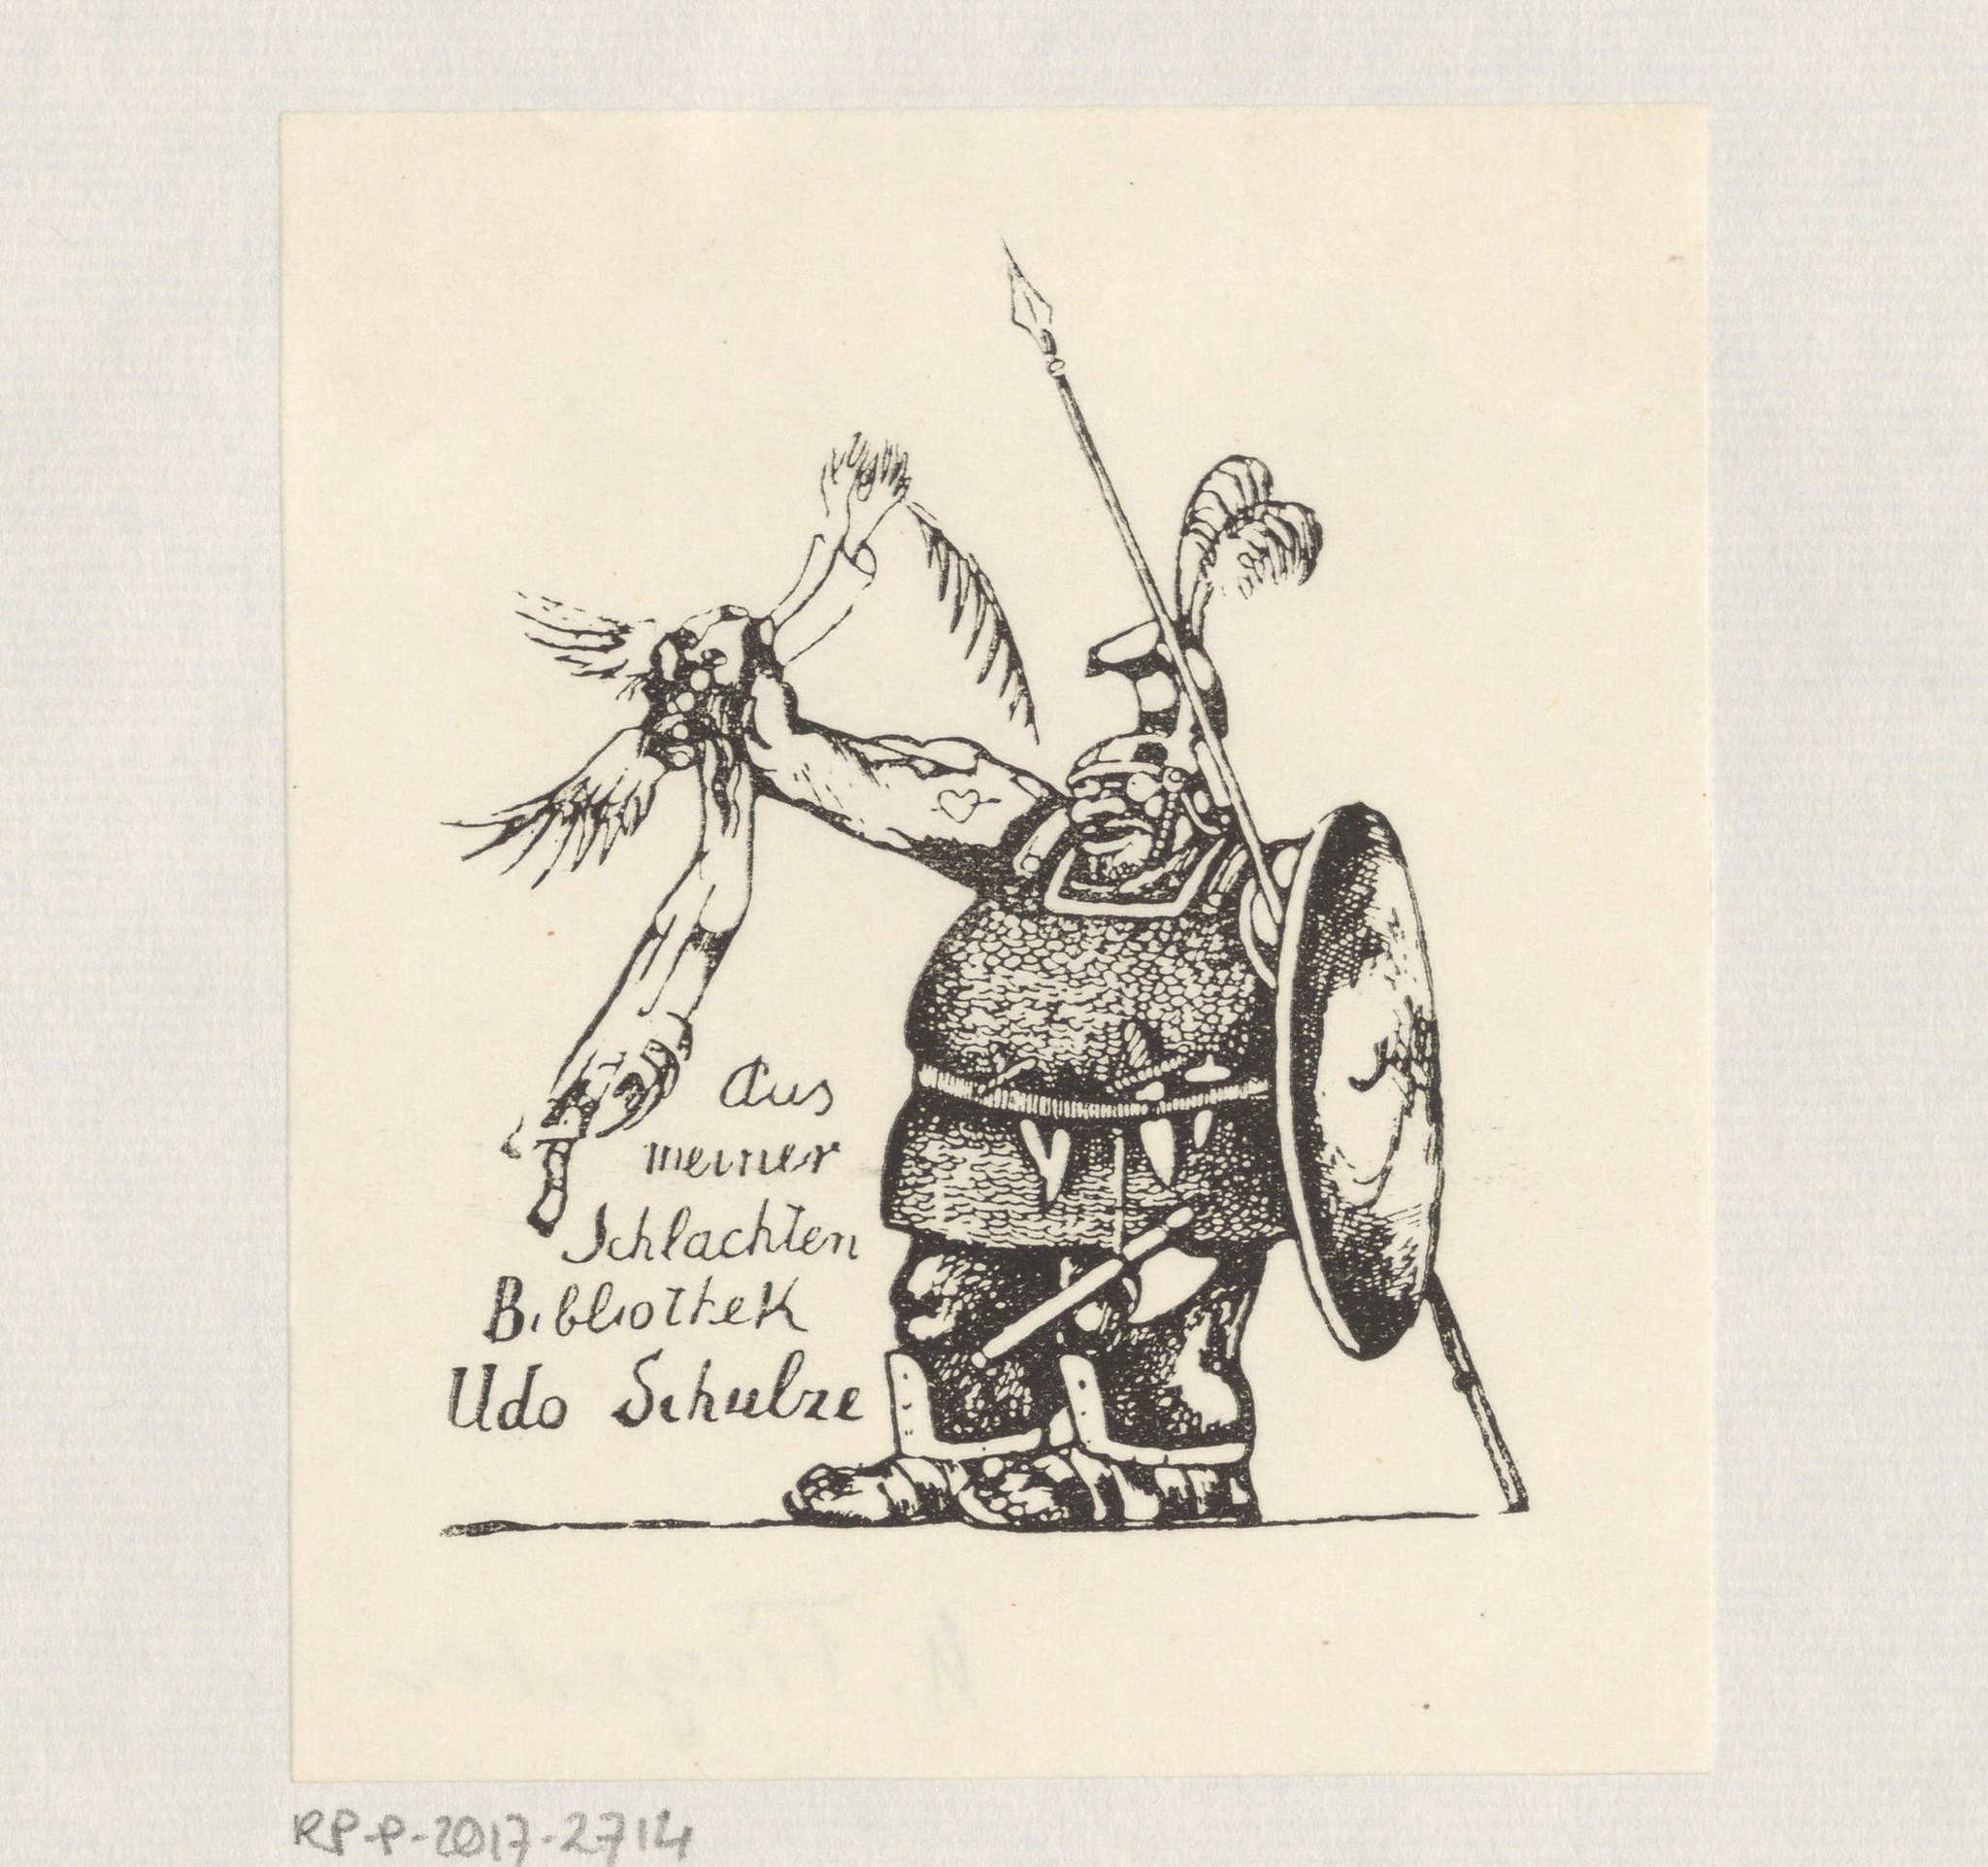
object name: bookplate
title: Ex libris van Udo Schulze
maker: michel fingesten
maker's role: painter, print maker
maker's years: 1884-1943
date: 1894-1943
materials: paper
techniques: lithograph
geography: italy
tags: armour, historical costume, the soldier; the soldier's life, angels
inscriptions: signature: ‘M. Fingesten’